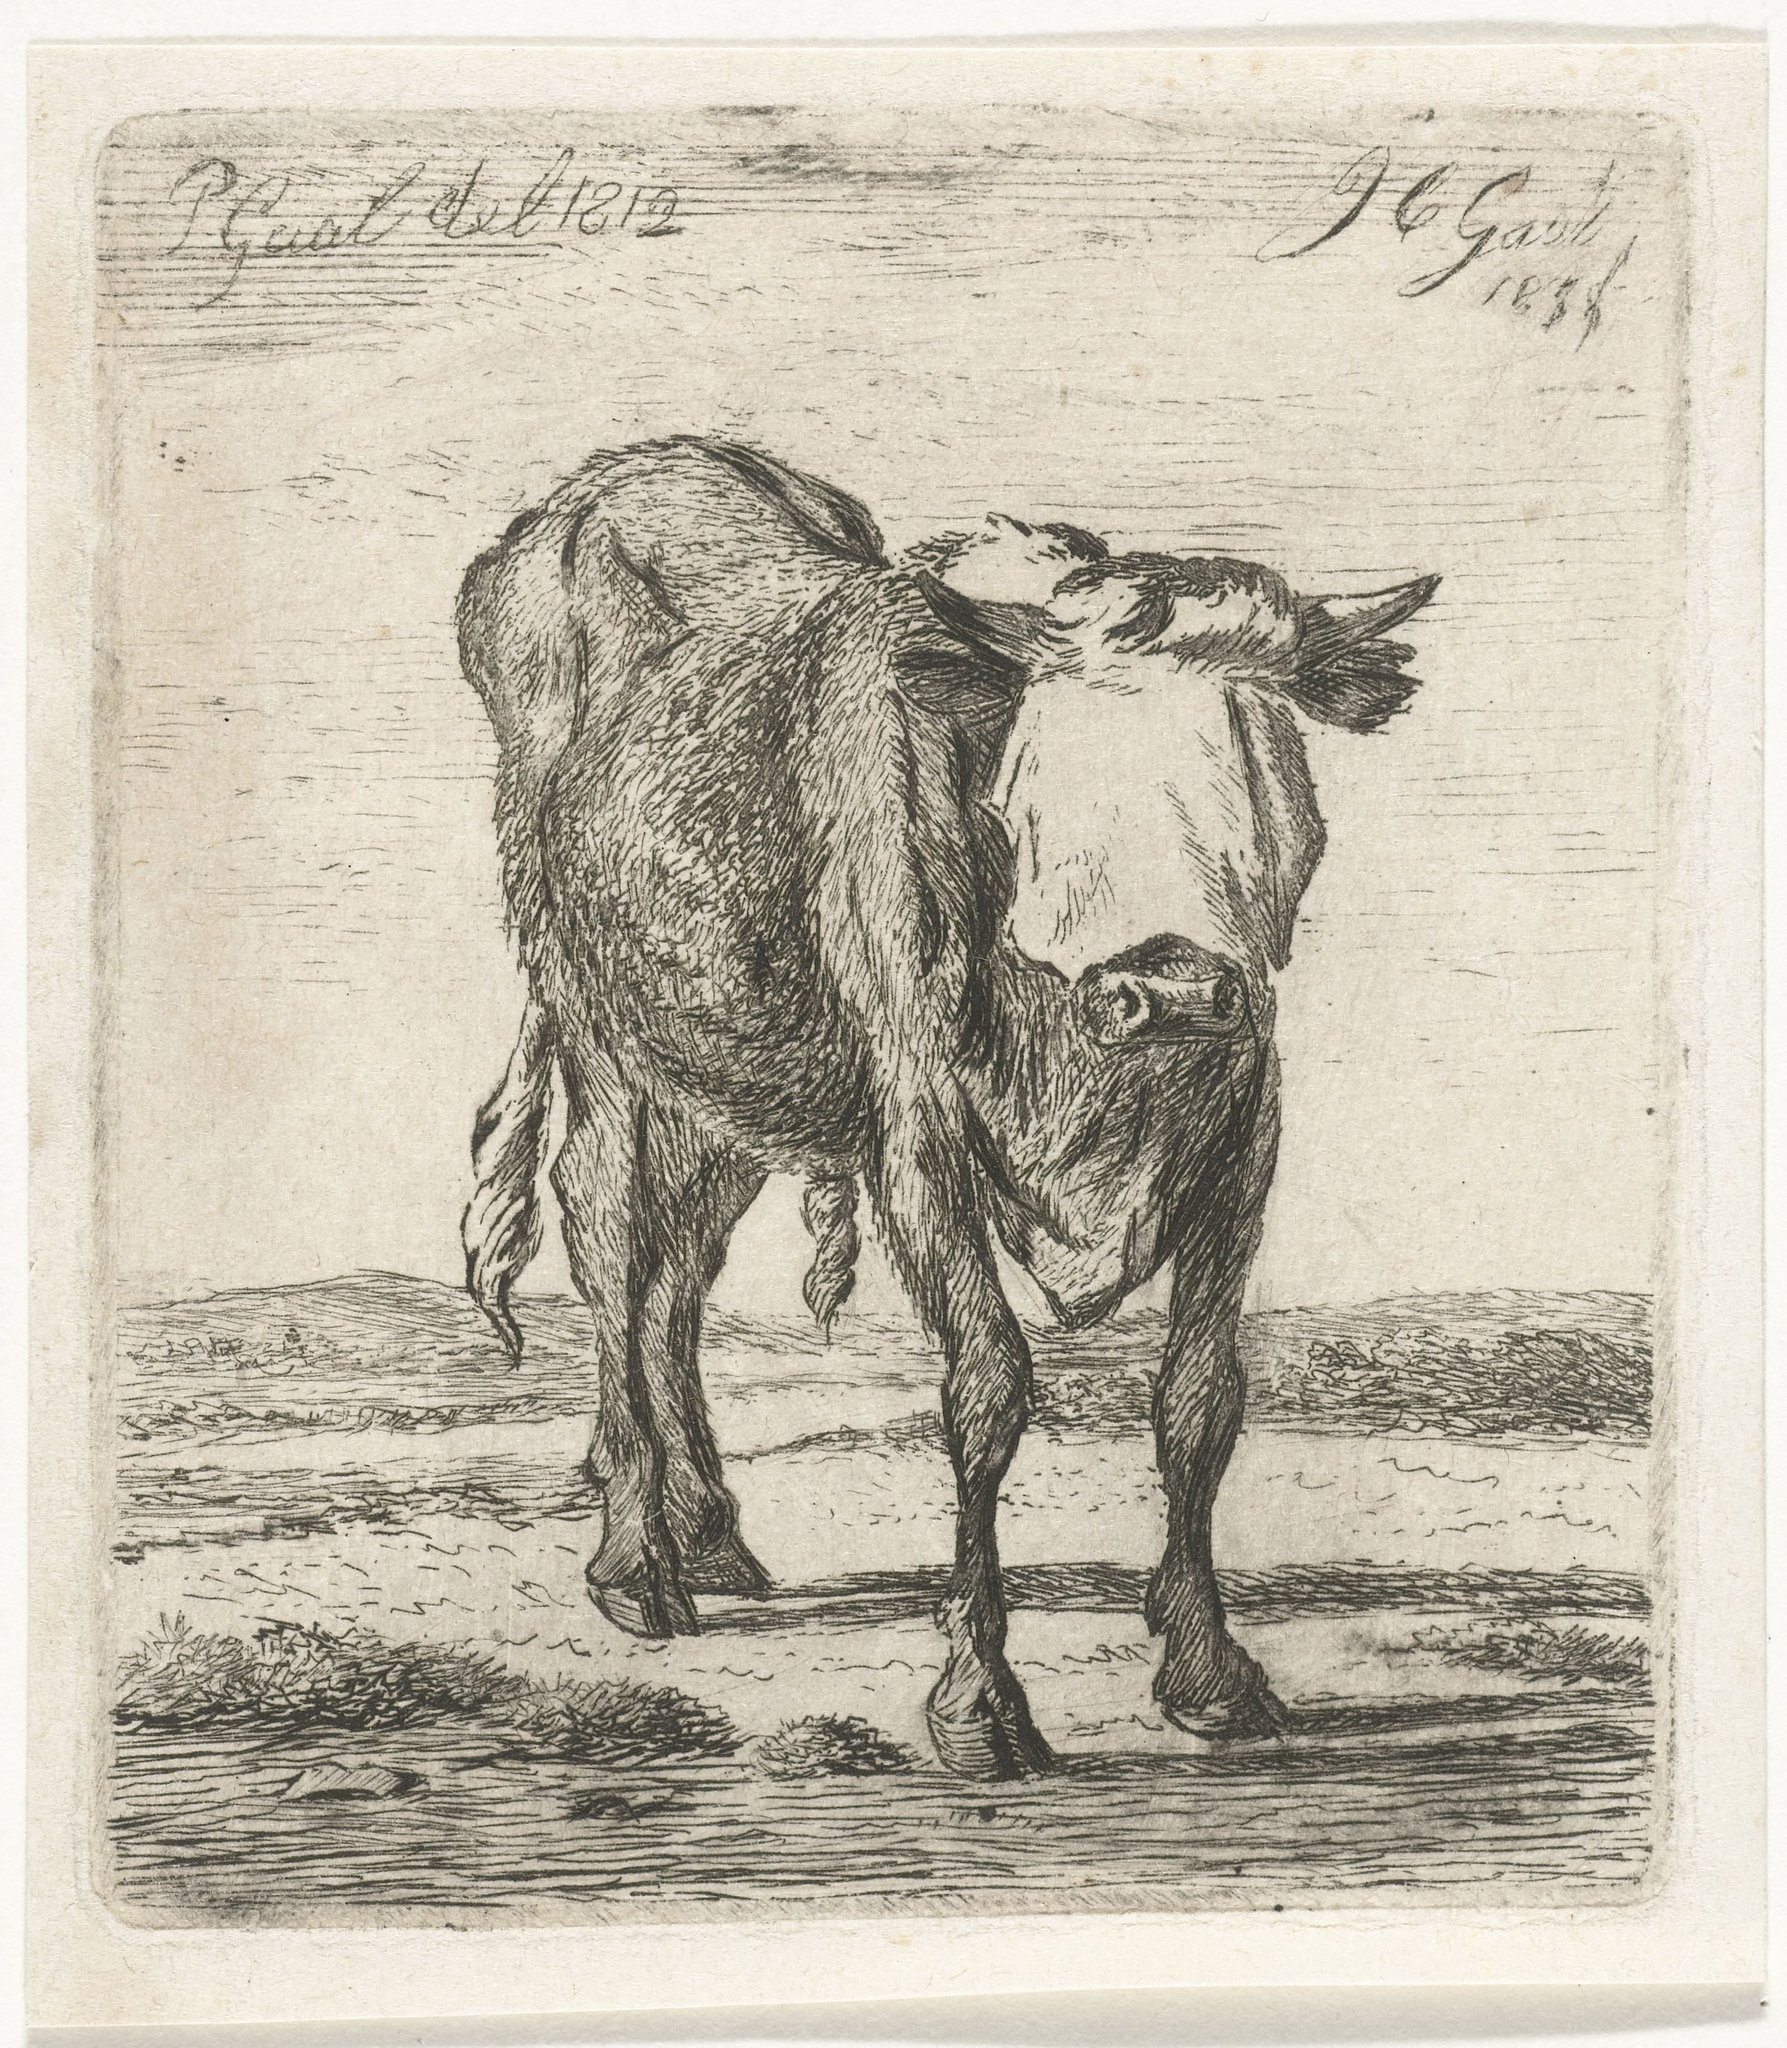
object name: print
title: Geblinddoekte stier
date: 1858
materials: paper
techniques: etching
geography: netherlands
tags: bullfight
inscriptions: collector's mark: Lugt 2228